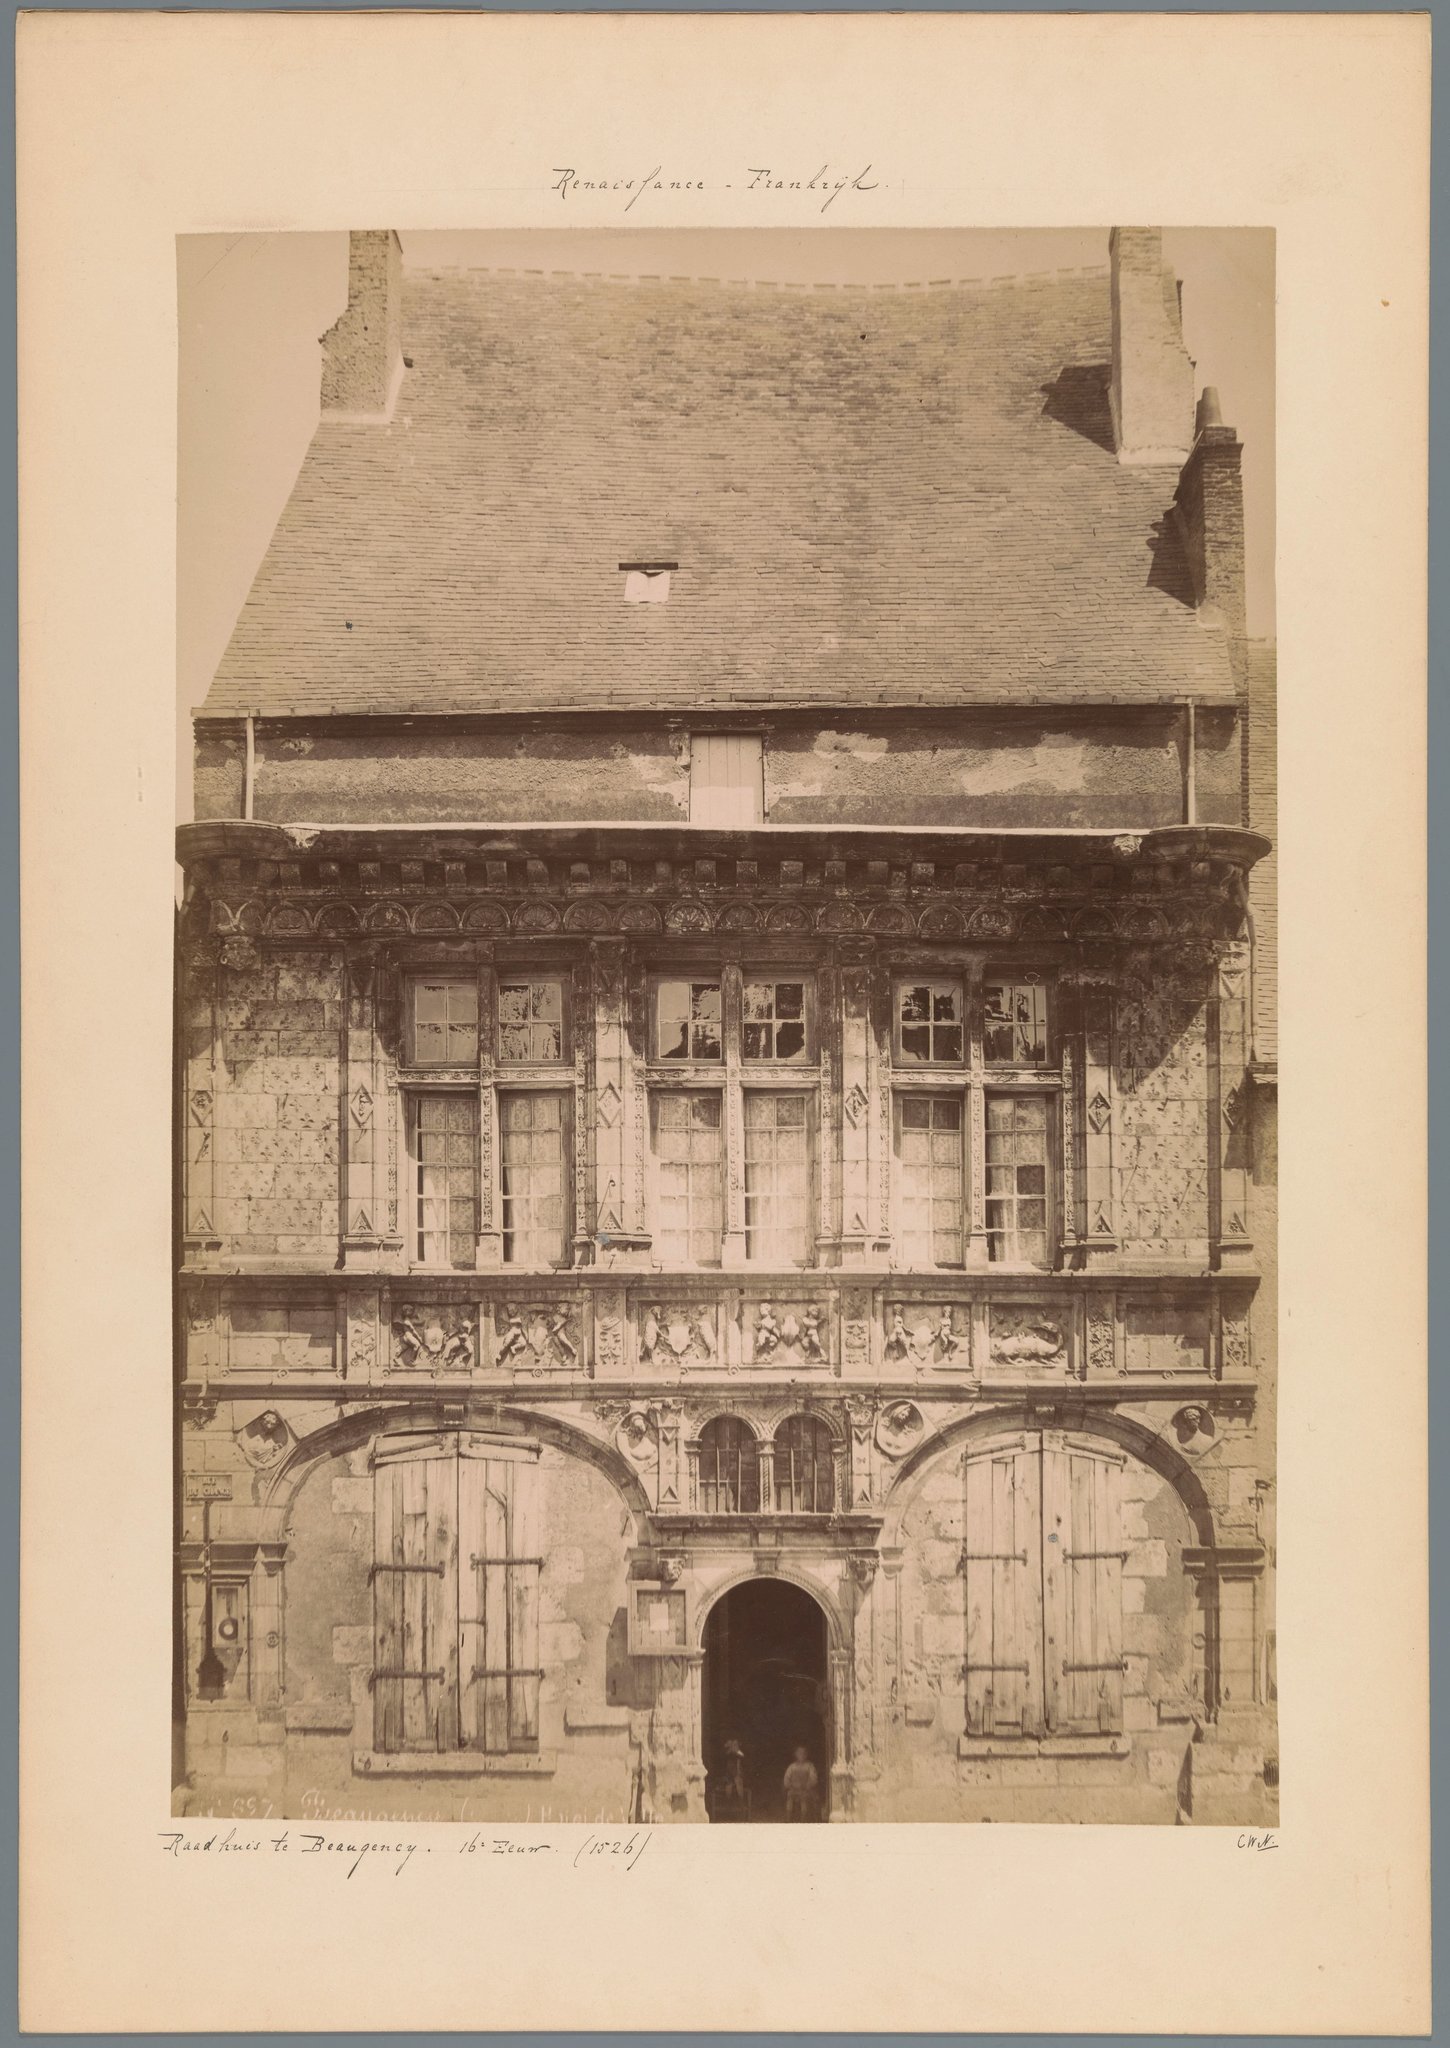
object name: photograph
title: Beaugency (Loiret) Hôtel de Ville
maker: séraphin-médéric mieusement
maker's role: fotograaf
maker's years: 1840-1905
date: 1875-1900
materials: cardboard, photographic support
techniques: albumen print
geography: beaugency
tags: child, townhall, art (+ relief ~ sculpture), façade (of house or building)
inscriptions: inscription: ‘Renaissance - Frankrijk. Raadhuis te Beaugency . 16e Eeuw. (1526)’, collector's mark: ‘INSTITUUT VOOR KUNST- NIJVERHEIDSONDERWIJS GABRIËL METSUSTRAAT No. 16. AMSTERDAM’, collector's mark: ‘KUNSTNIJVERHEIDSCHOOL QUELLINUS AMSTERDAM FRANS HALSSTRAAT 14.’, number: ‘No. 627’, inscription: ‘CWN.’